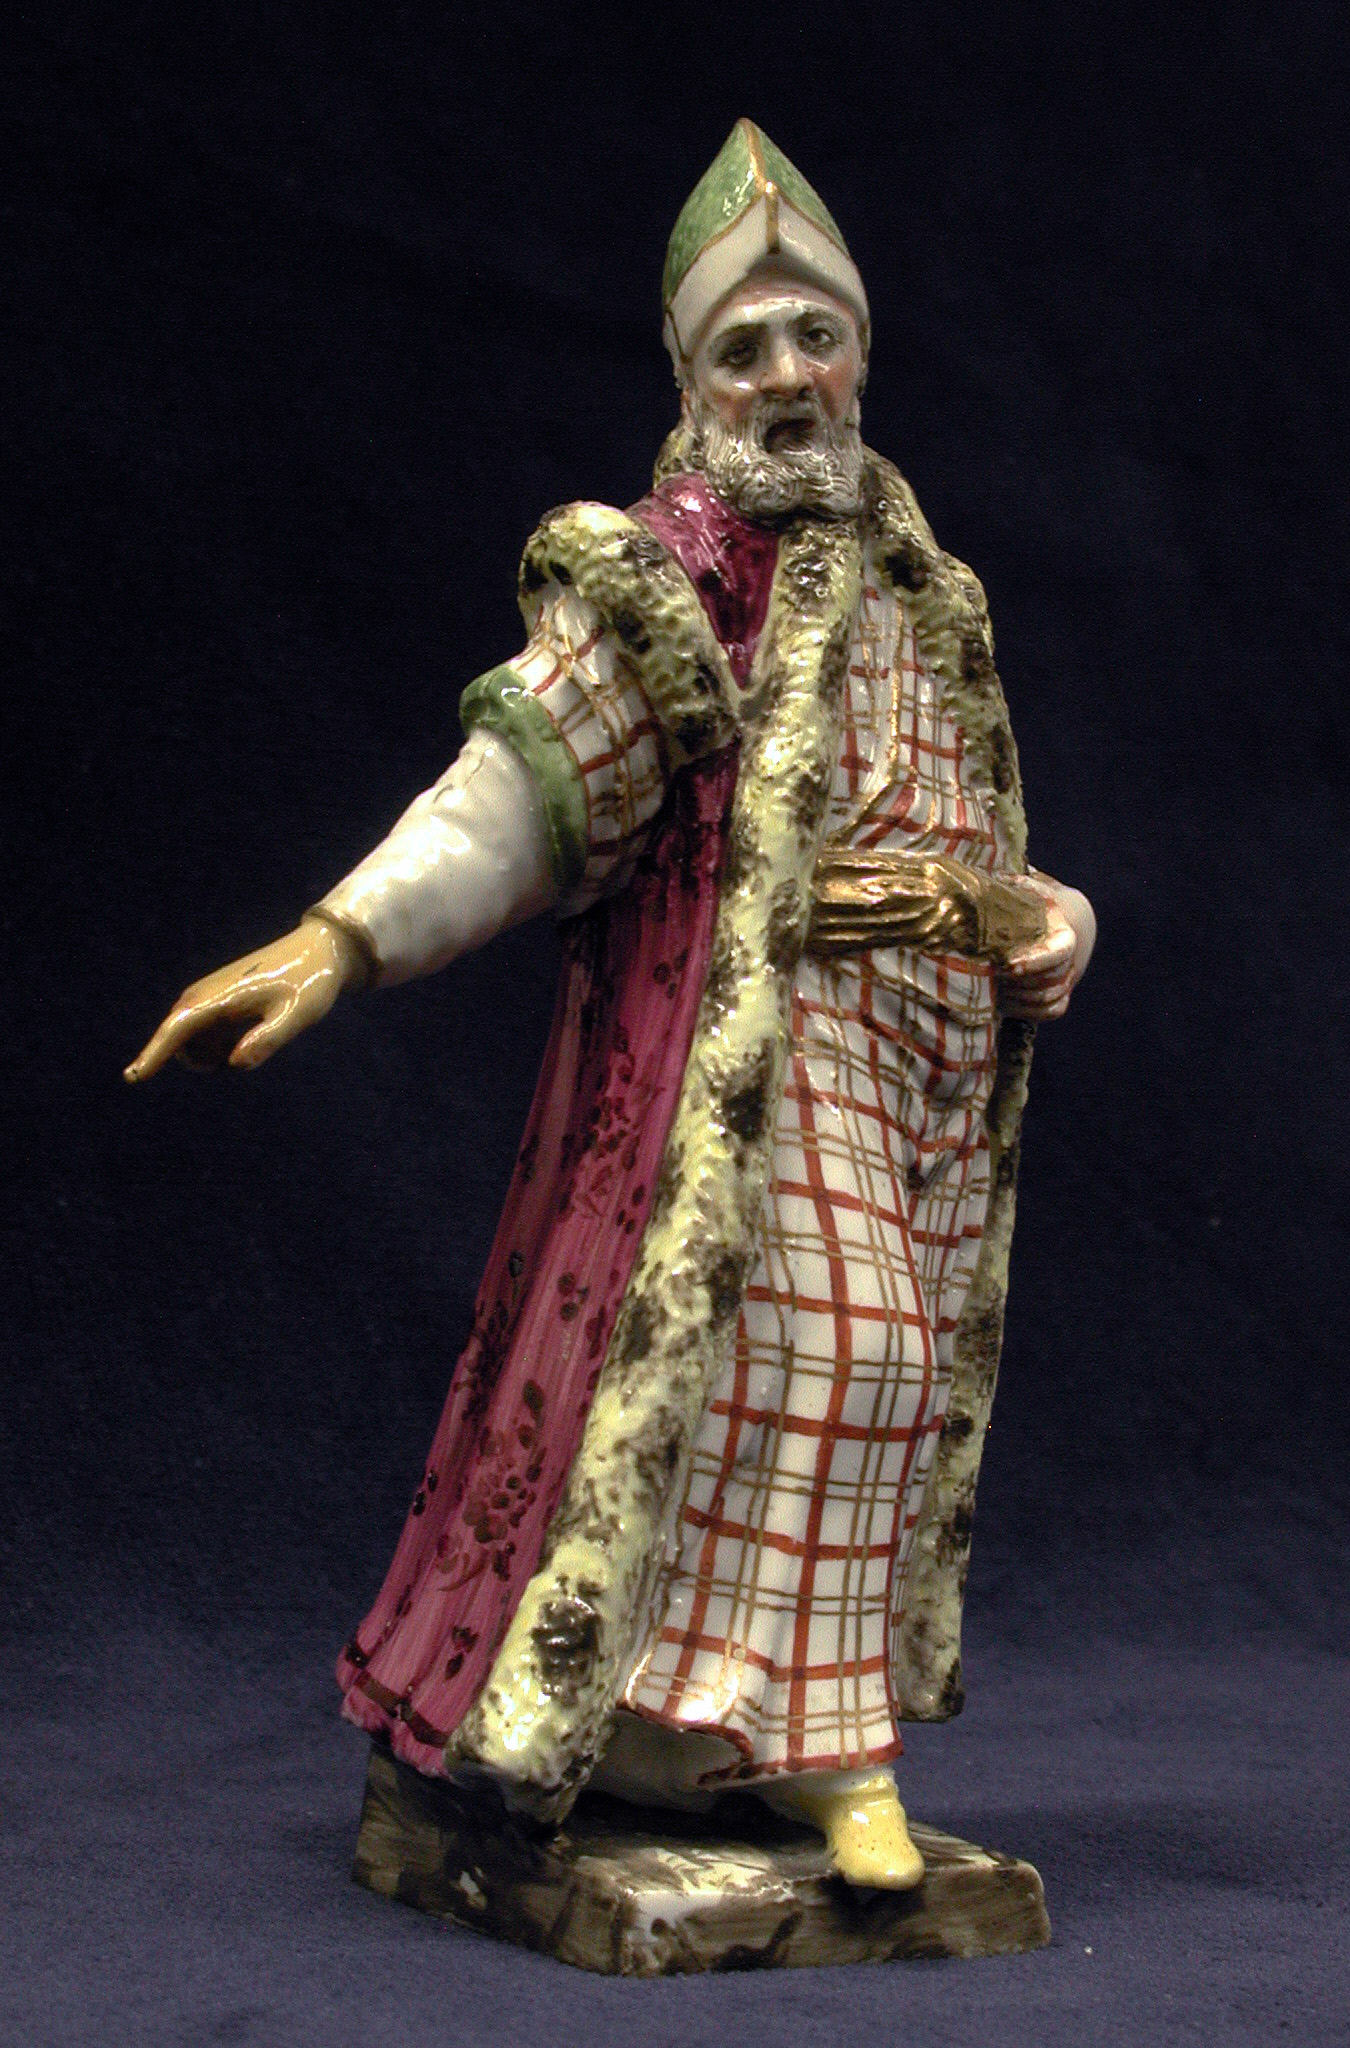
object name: figure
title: Turk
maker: doccia porcelain manufactory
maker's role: manufactory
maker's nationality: italian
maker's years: 1737-1896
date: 1760-1770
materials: hard paste porcelain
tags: men